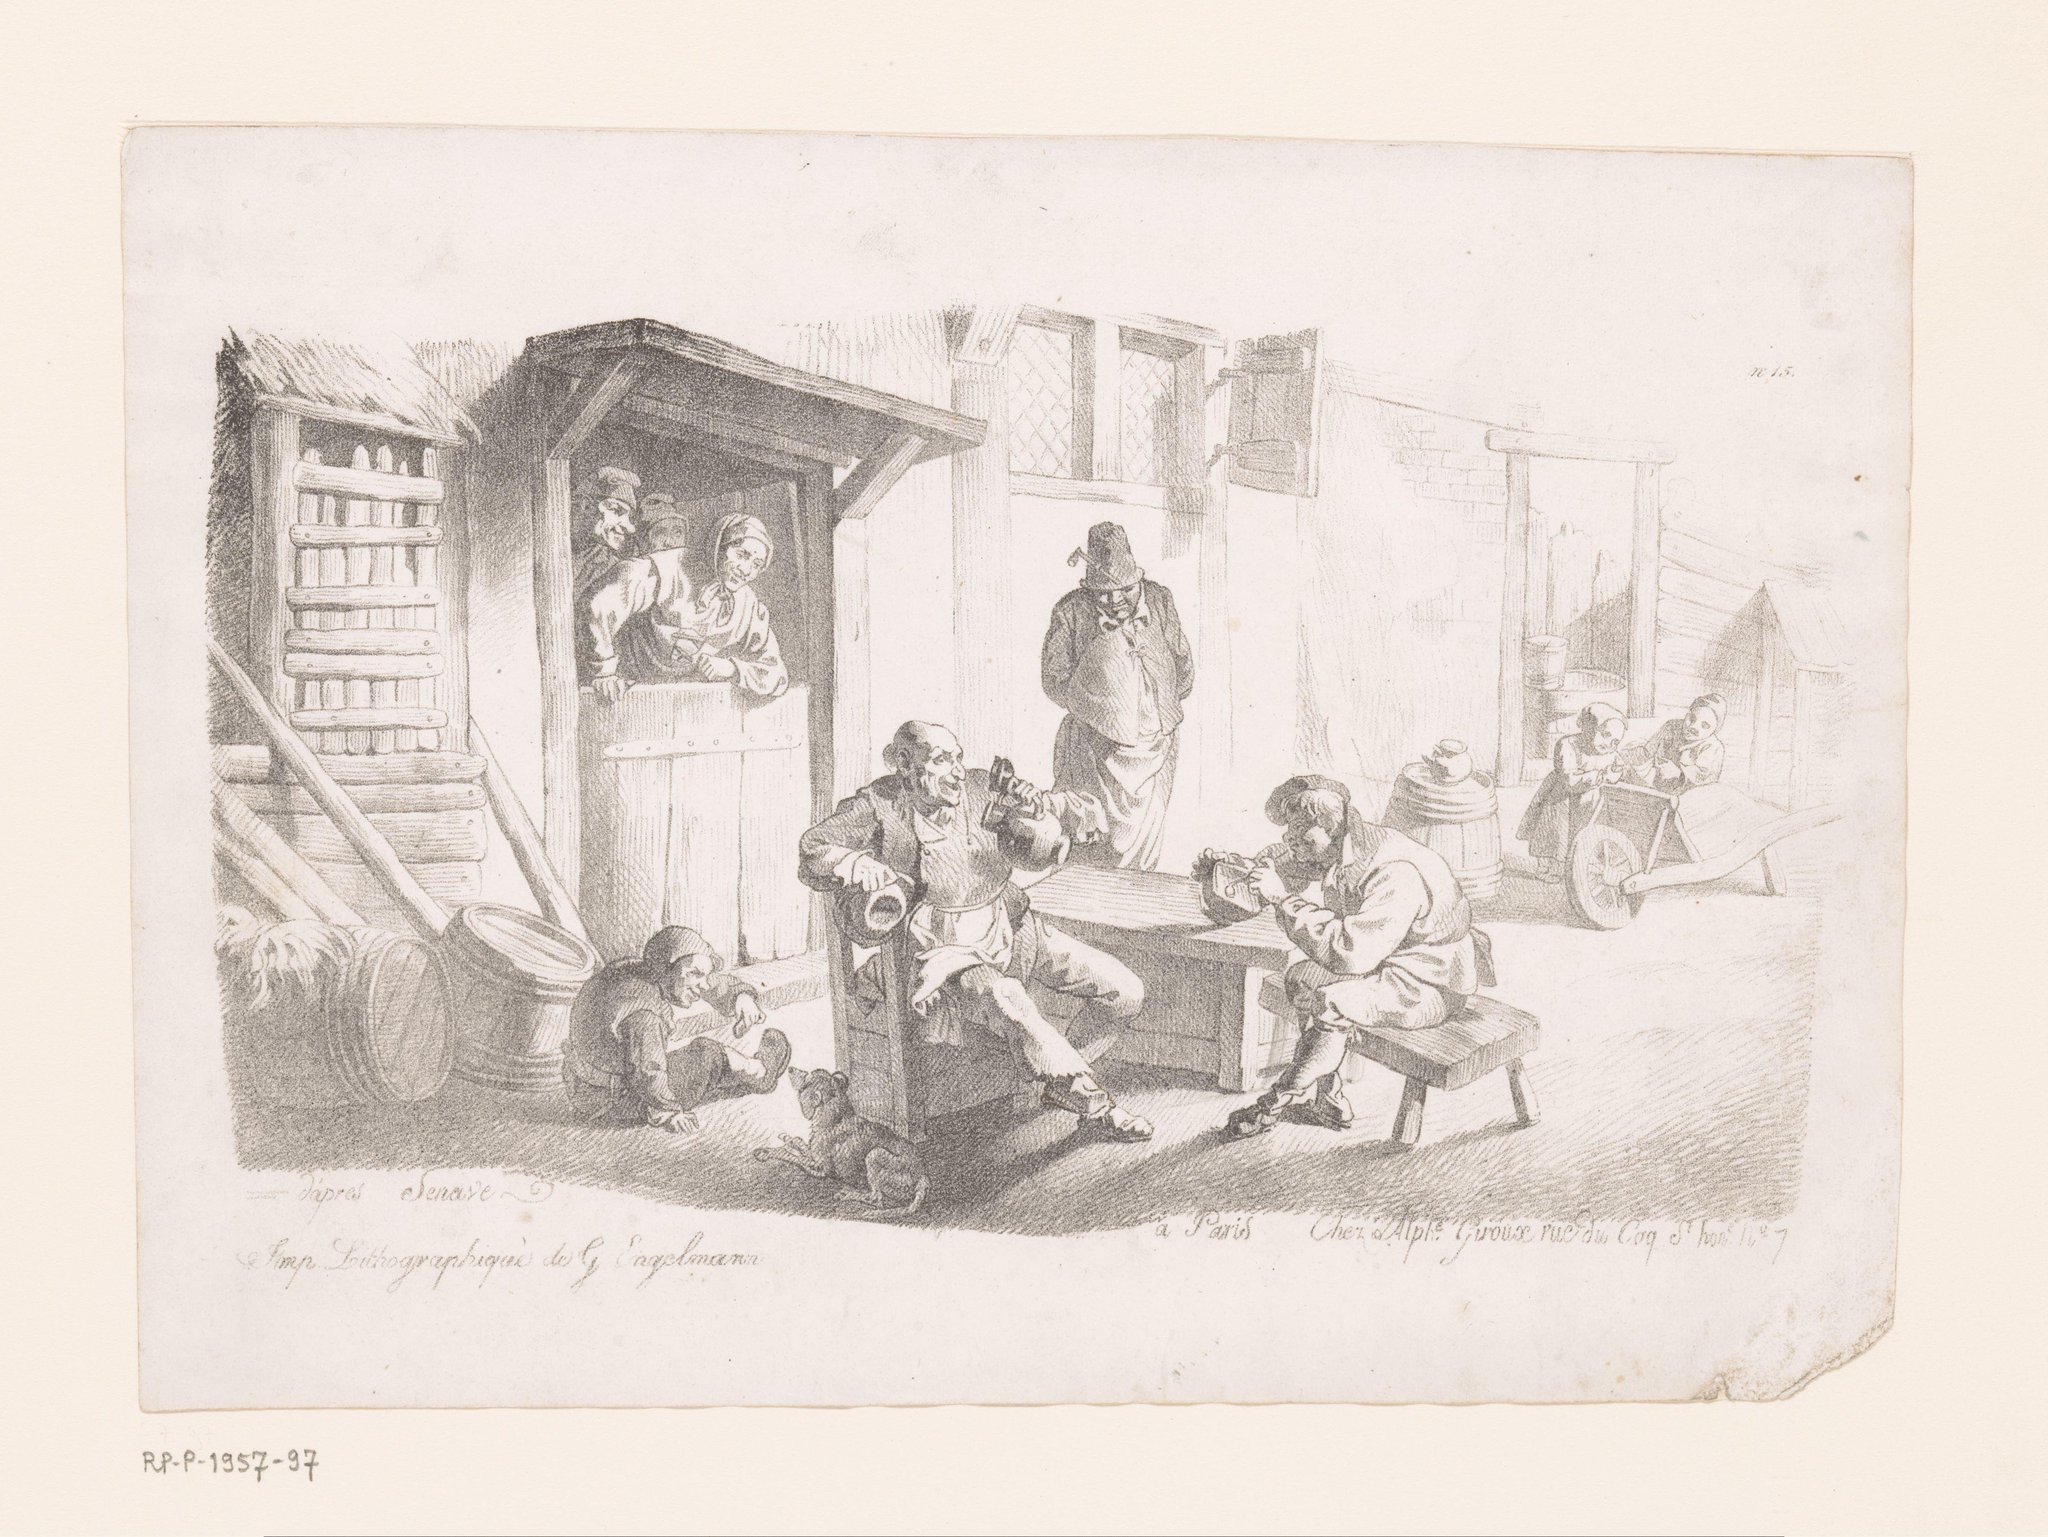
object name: print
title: Gezelschap voor een herberg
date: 1816-1839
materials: paper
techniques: lithograph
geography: paris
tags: inn, coffee-house, public house, etc., farmers, drinks, stimulants, drugs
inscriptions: collector's mark: Lugt 2228a